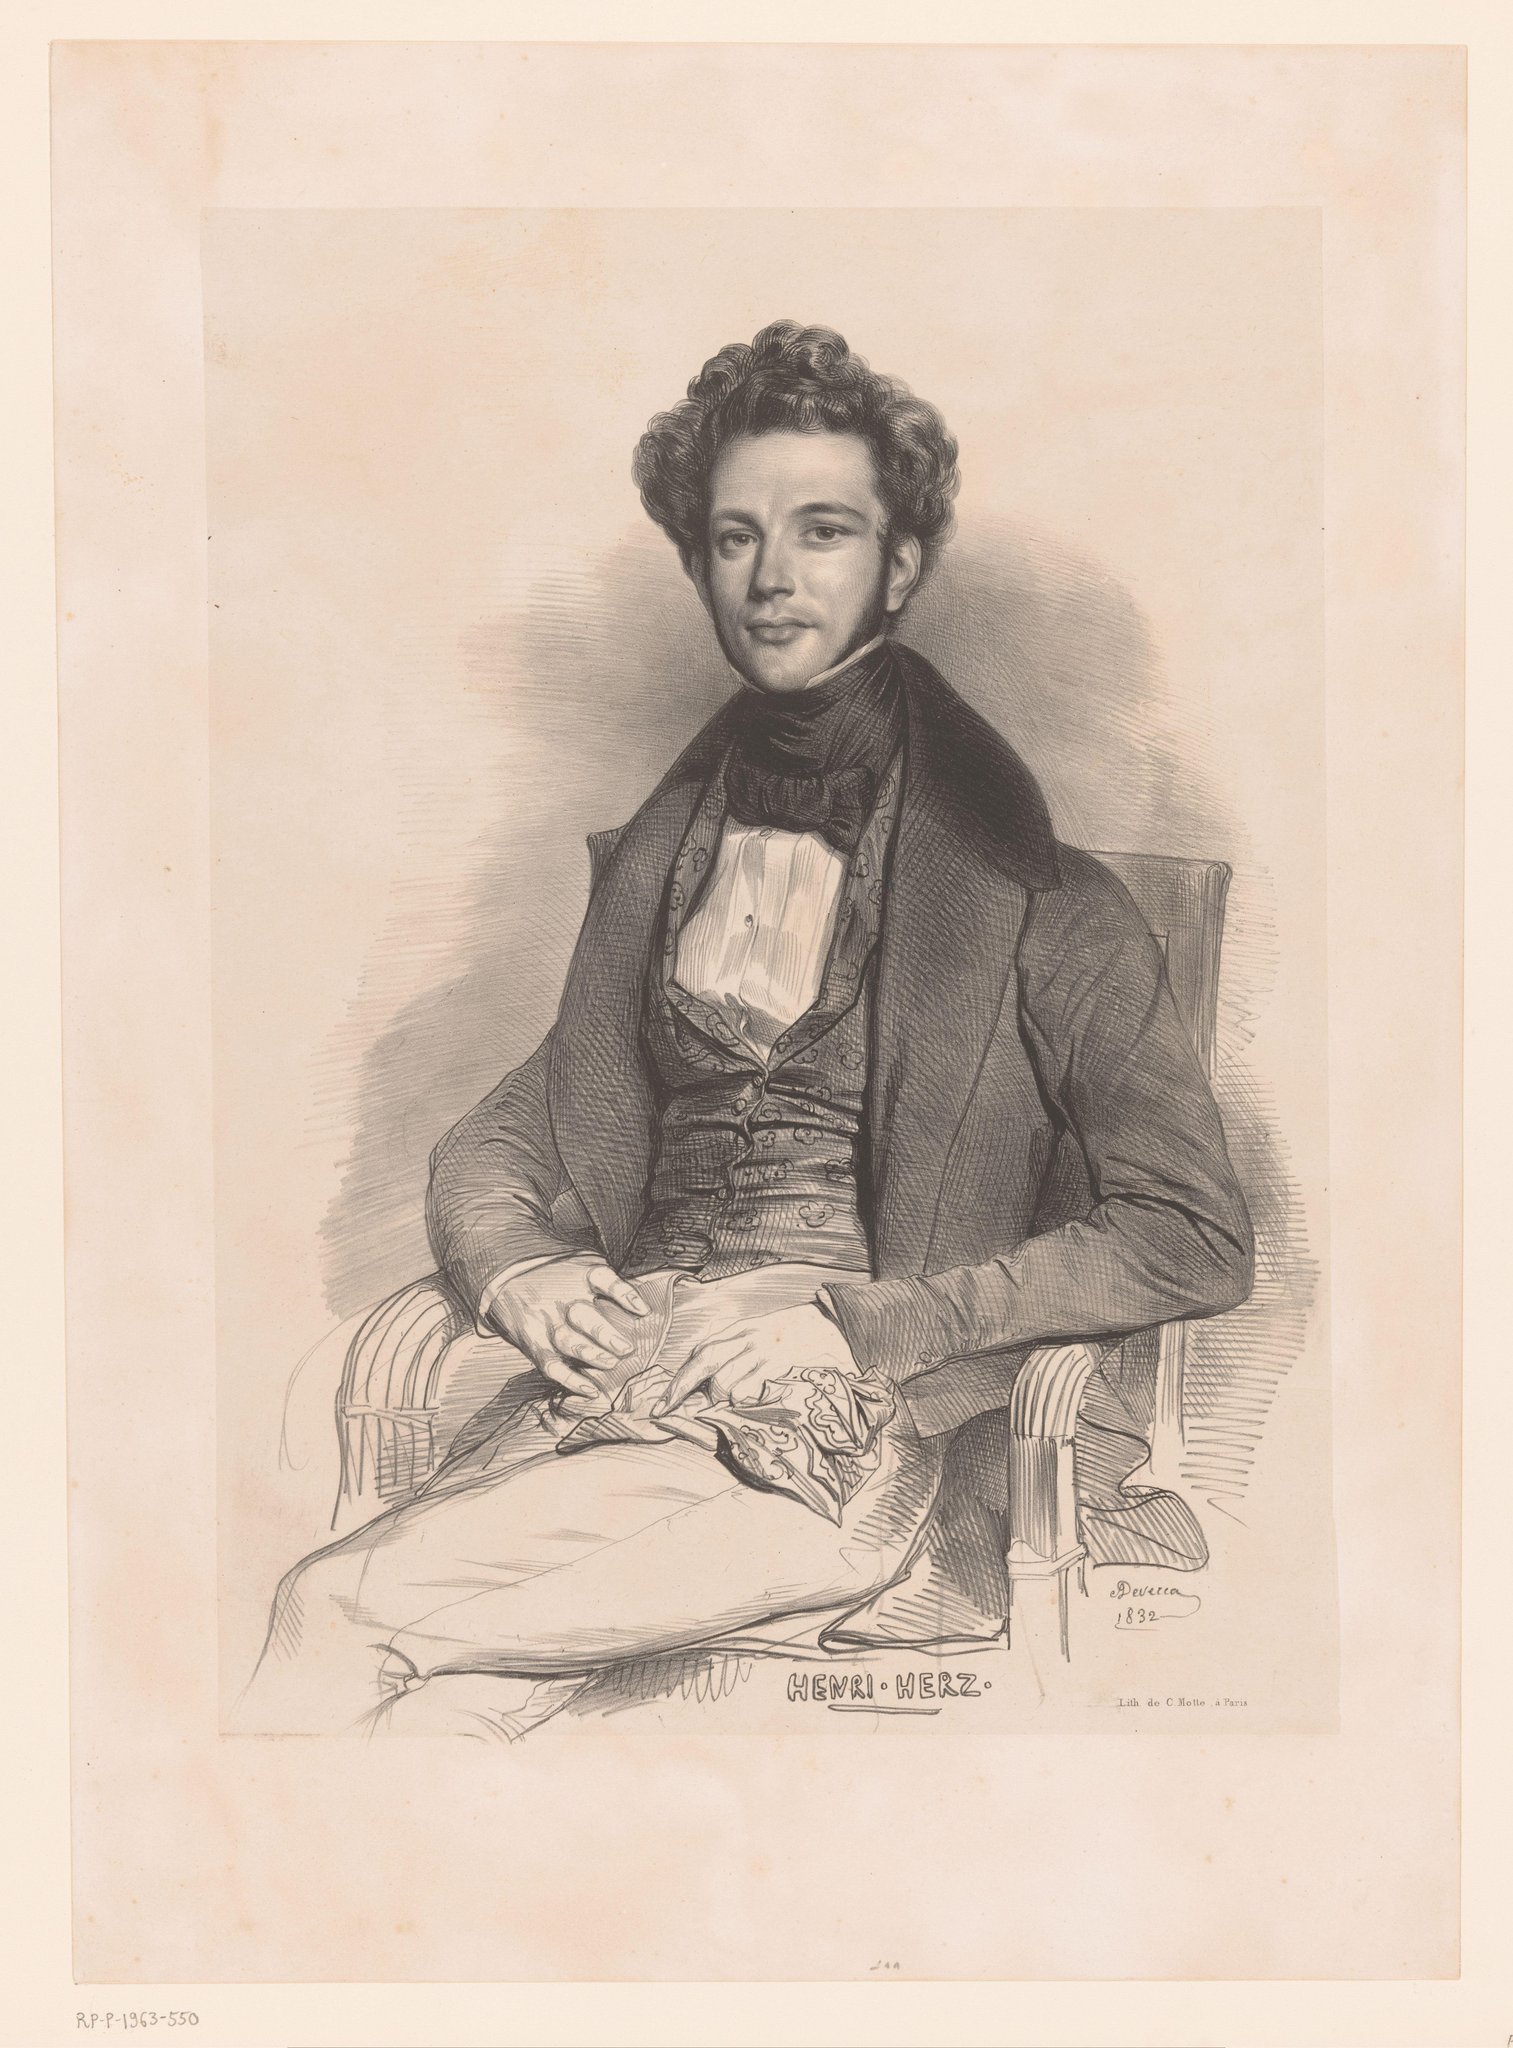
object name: print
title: Henri Herz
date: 1832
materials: paper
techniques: lithograph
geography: paris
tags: vienna, paris, henri herz, historical persons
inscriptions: collector's mark: Lugt 2228a